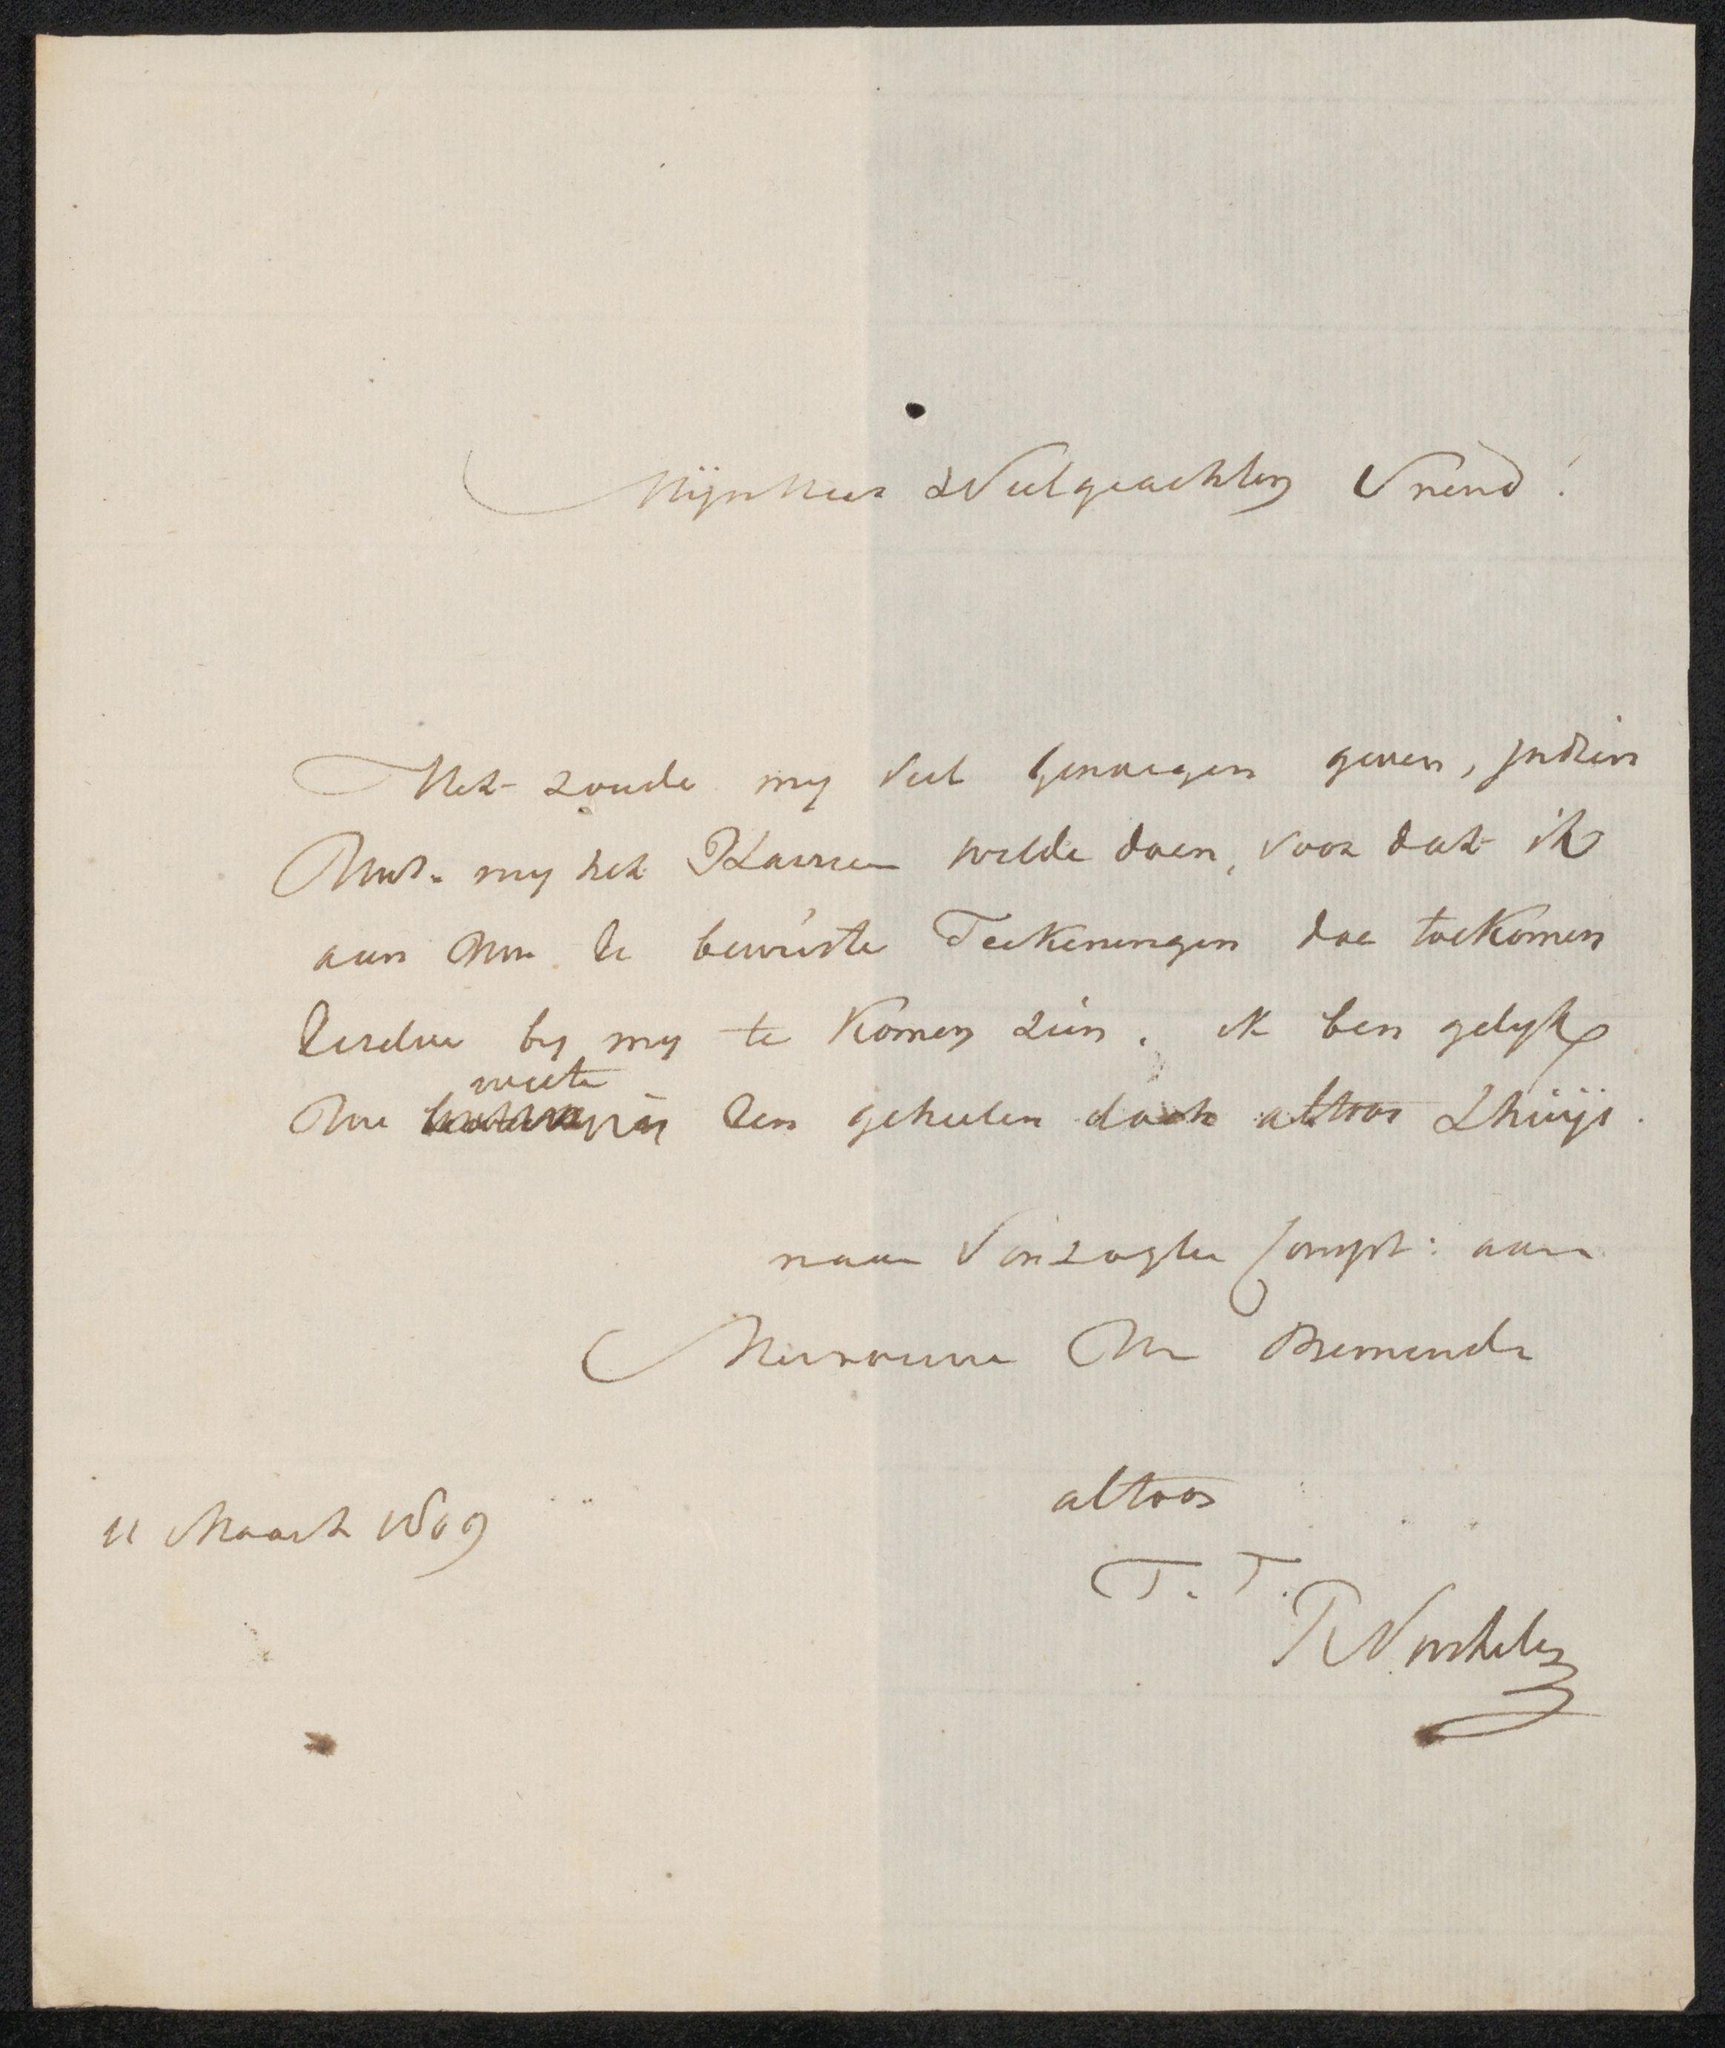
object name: letter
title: Brief aan anoniem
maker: reinier vinkeles (i)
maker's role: draughtsman, print maker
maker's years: 1741-1816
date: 1809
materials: ink, paper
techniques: pen, writing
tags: drawing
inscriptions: watermark